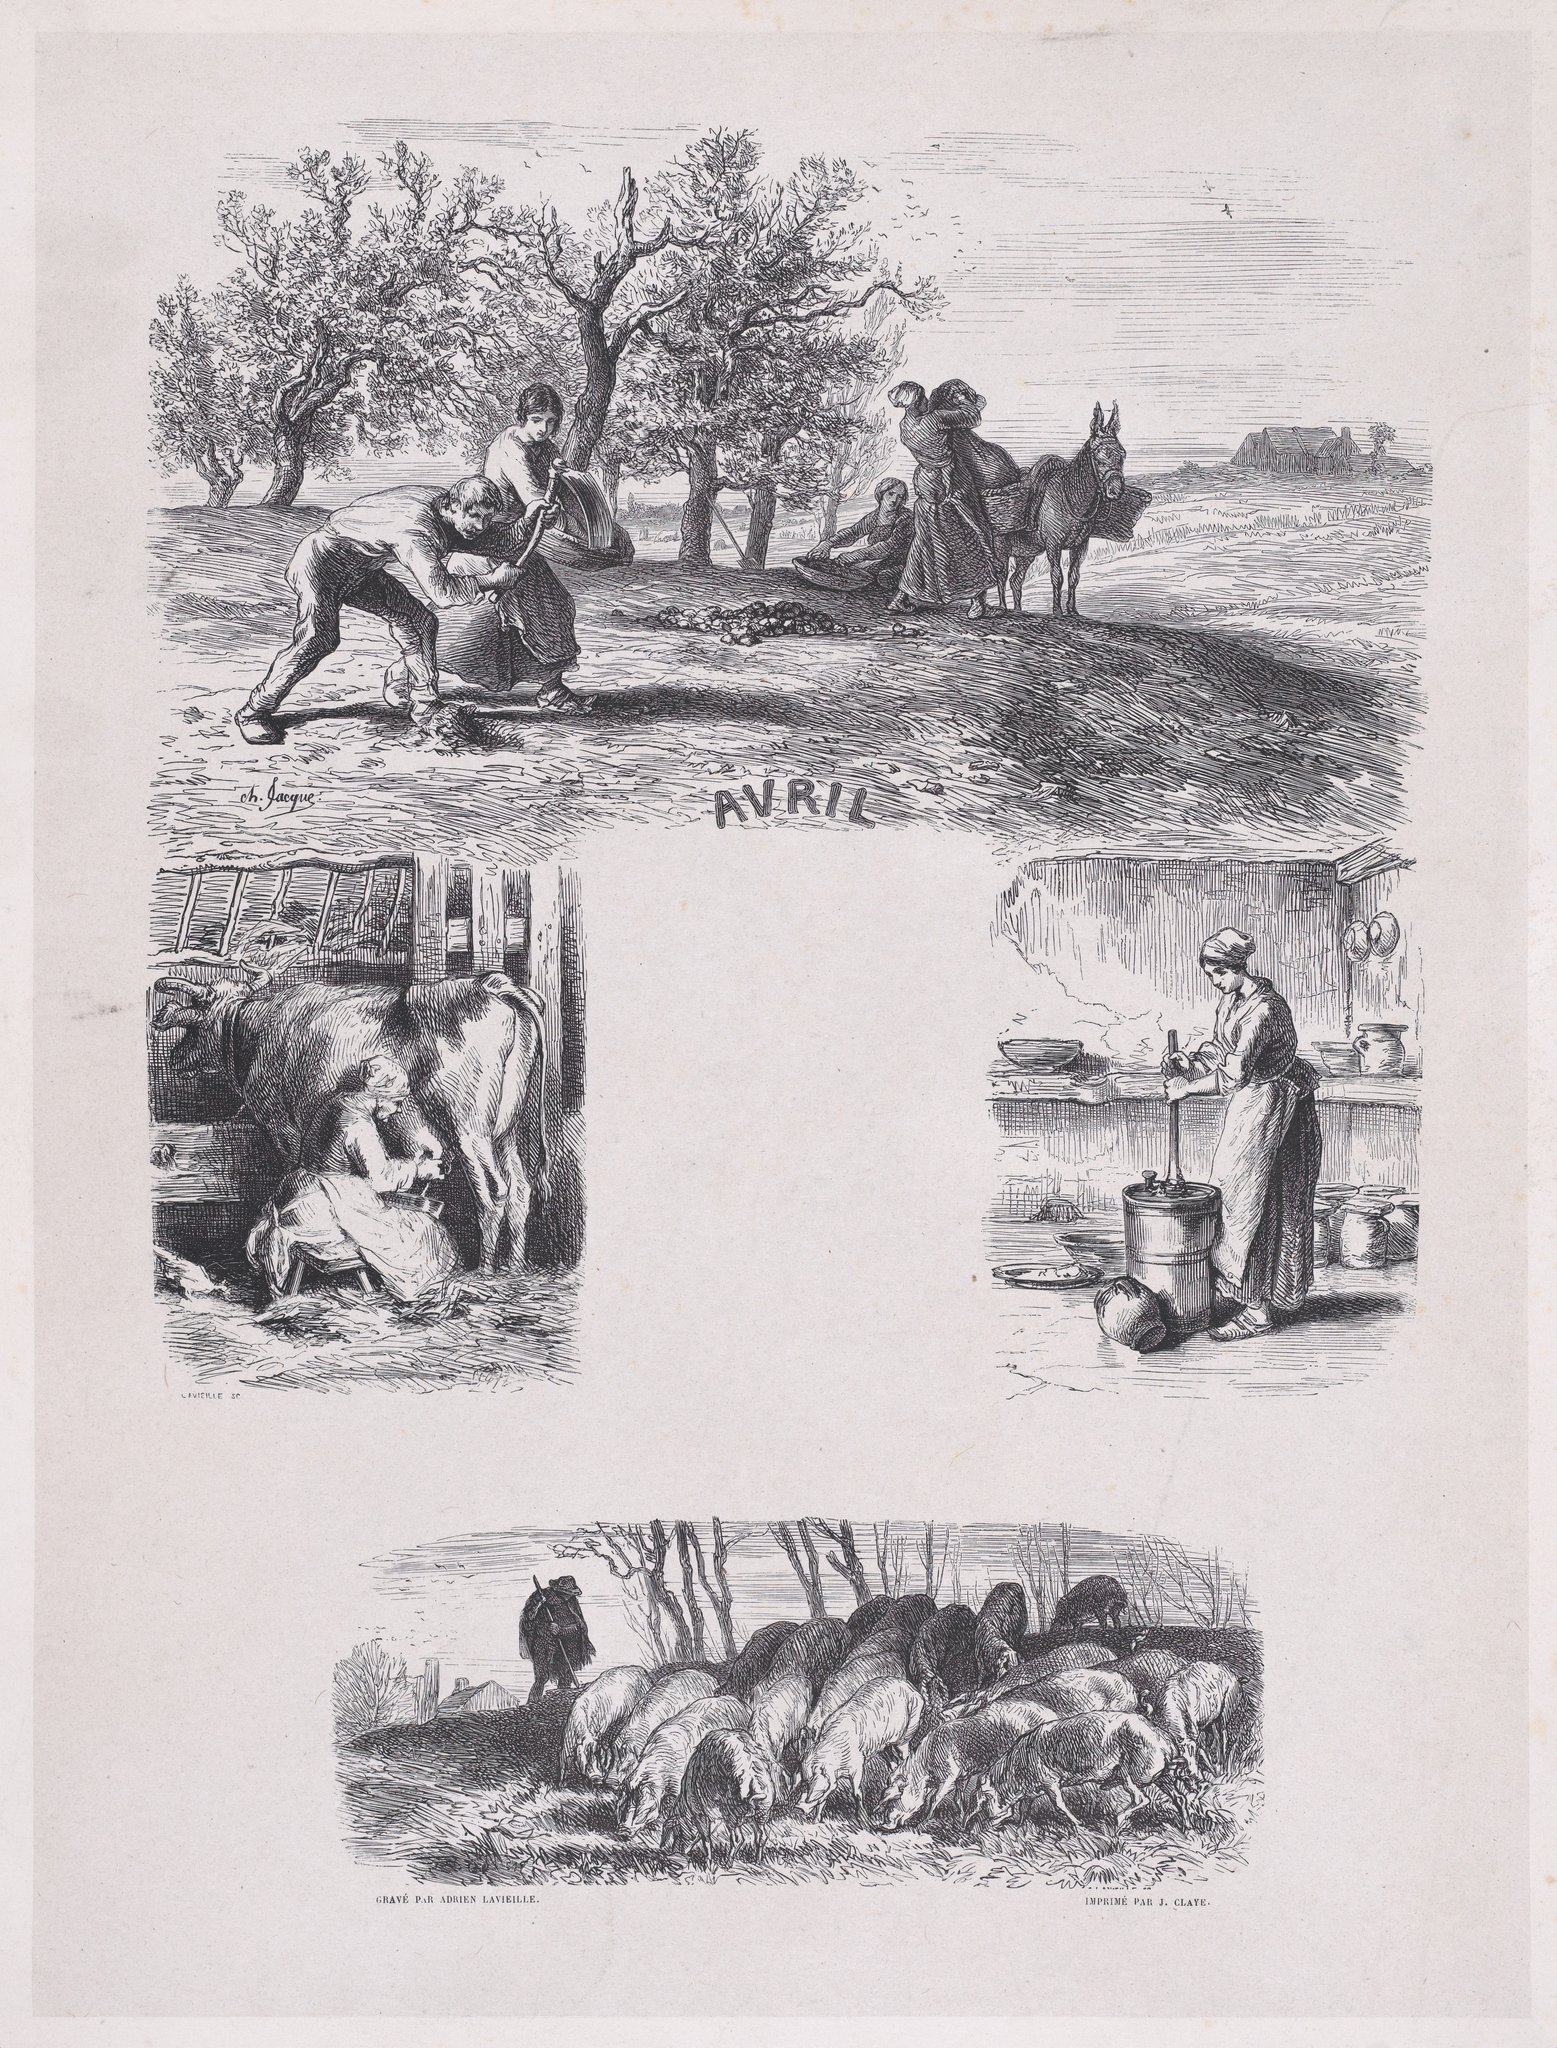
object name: print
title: April, from "Album of Rustic Subjects"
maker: charles émile jacque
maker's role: artist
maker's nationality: french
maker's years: 1813-1894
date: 1859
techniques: engraving